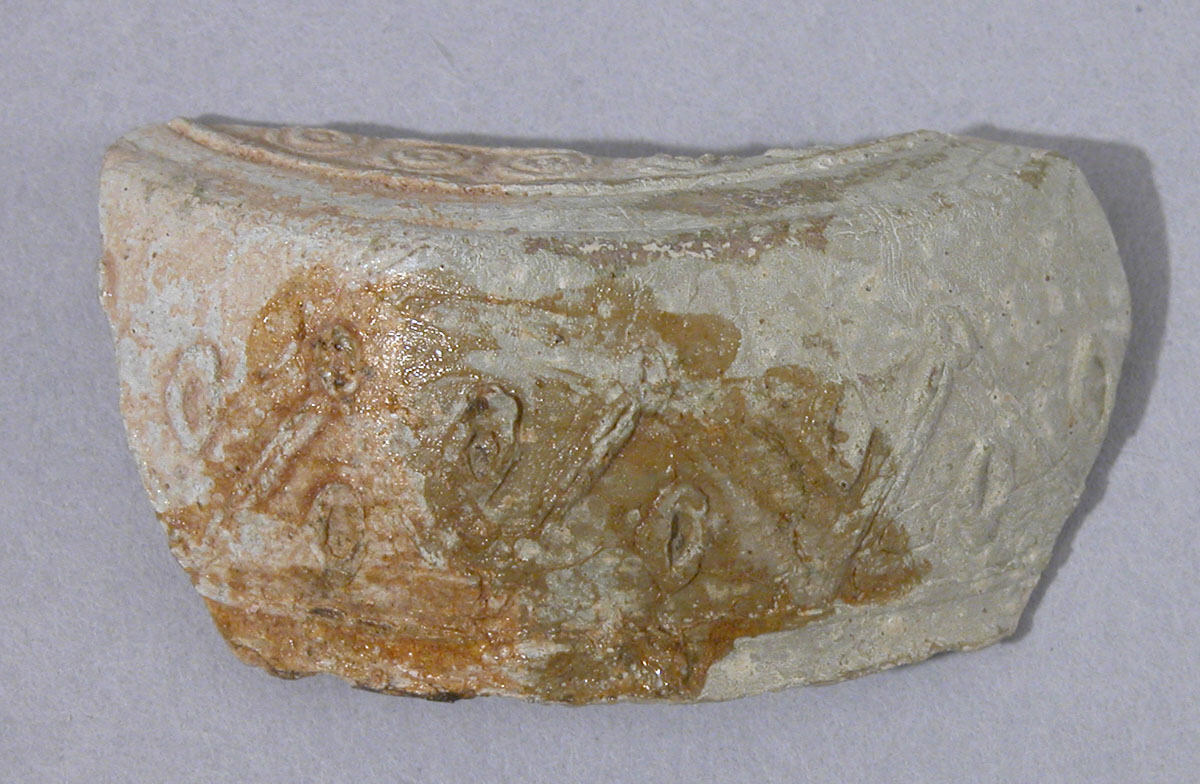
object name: fragment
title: Ceramic Fragment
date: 801-900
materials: earthenware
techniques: glazing, molding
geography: saudi arabia